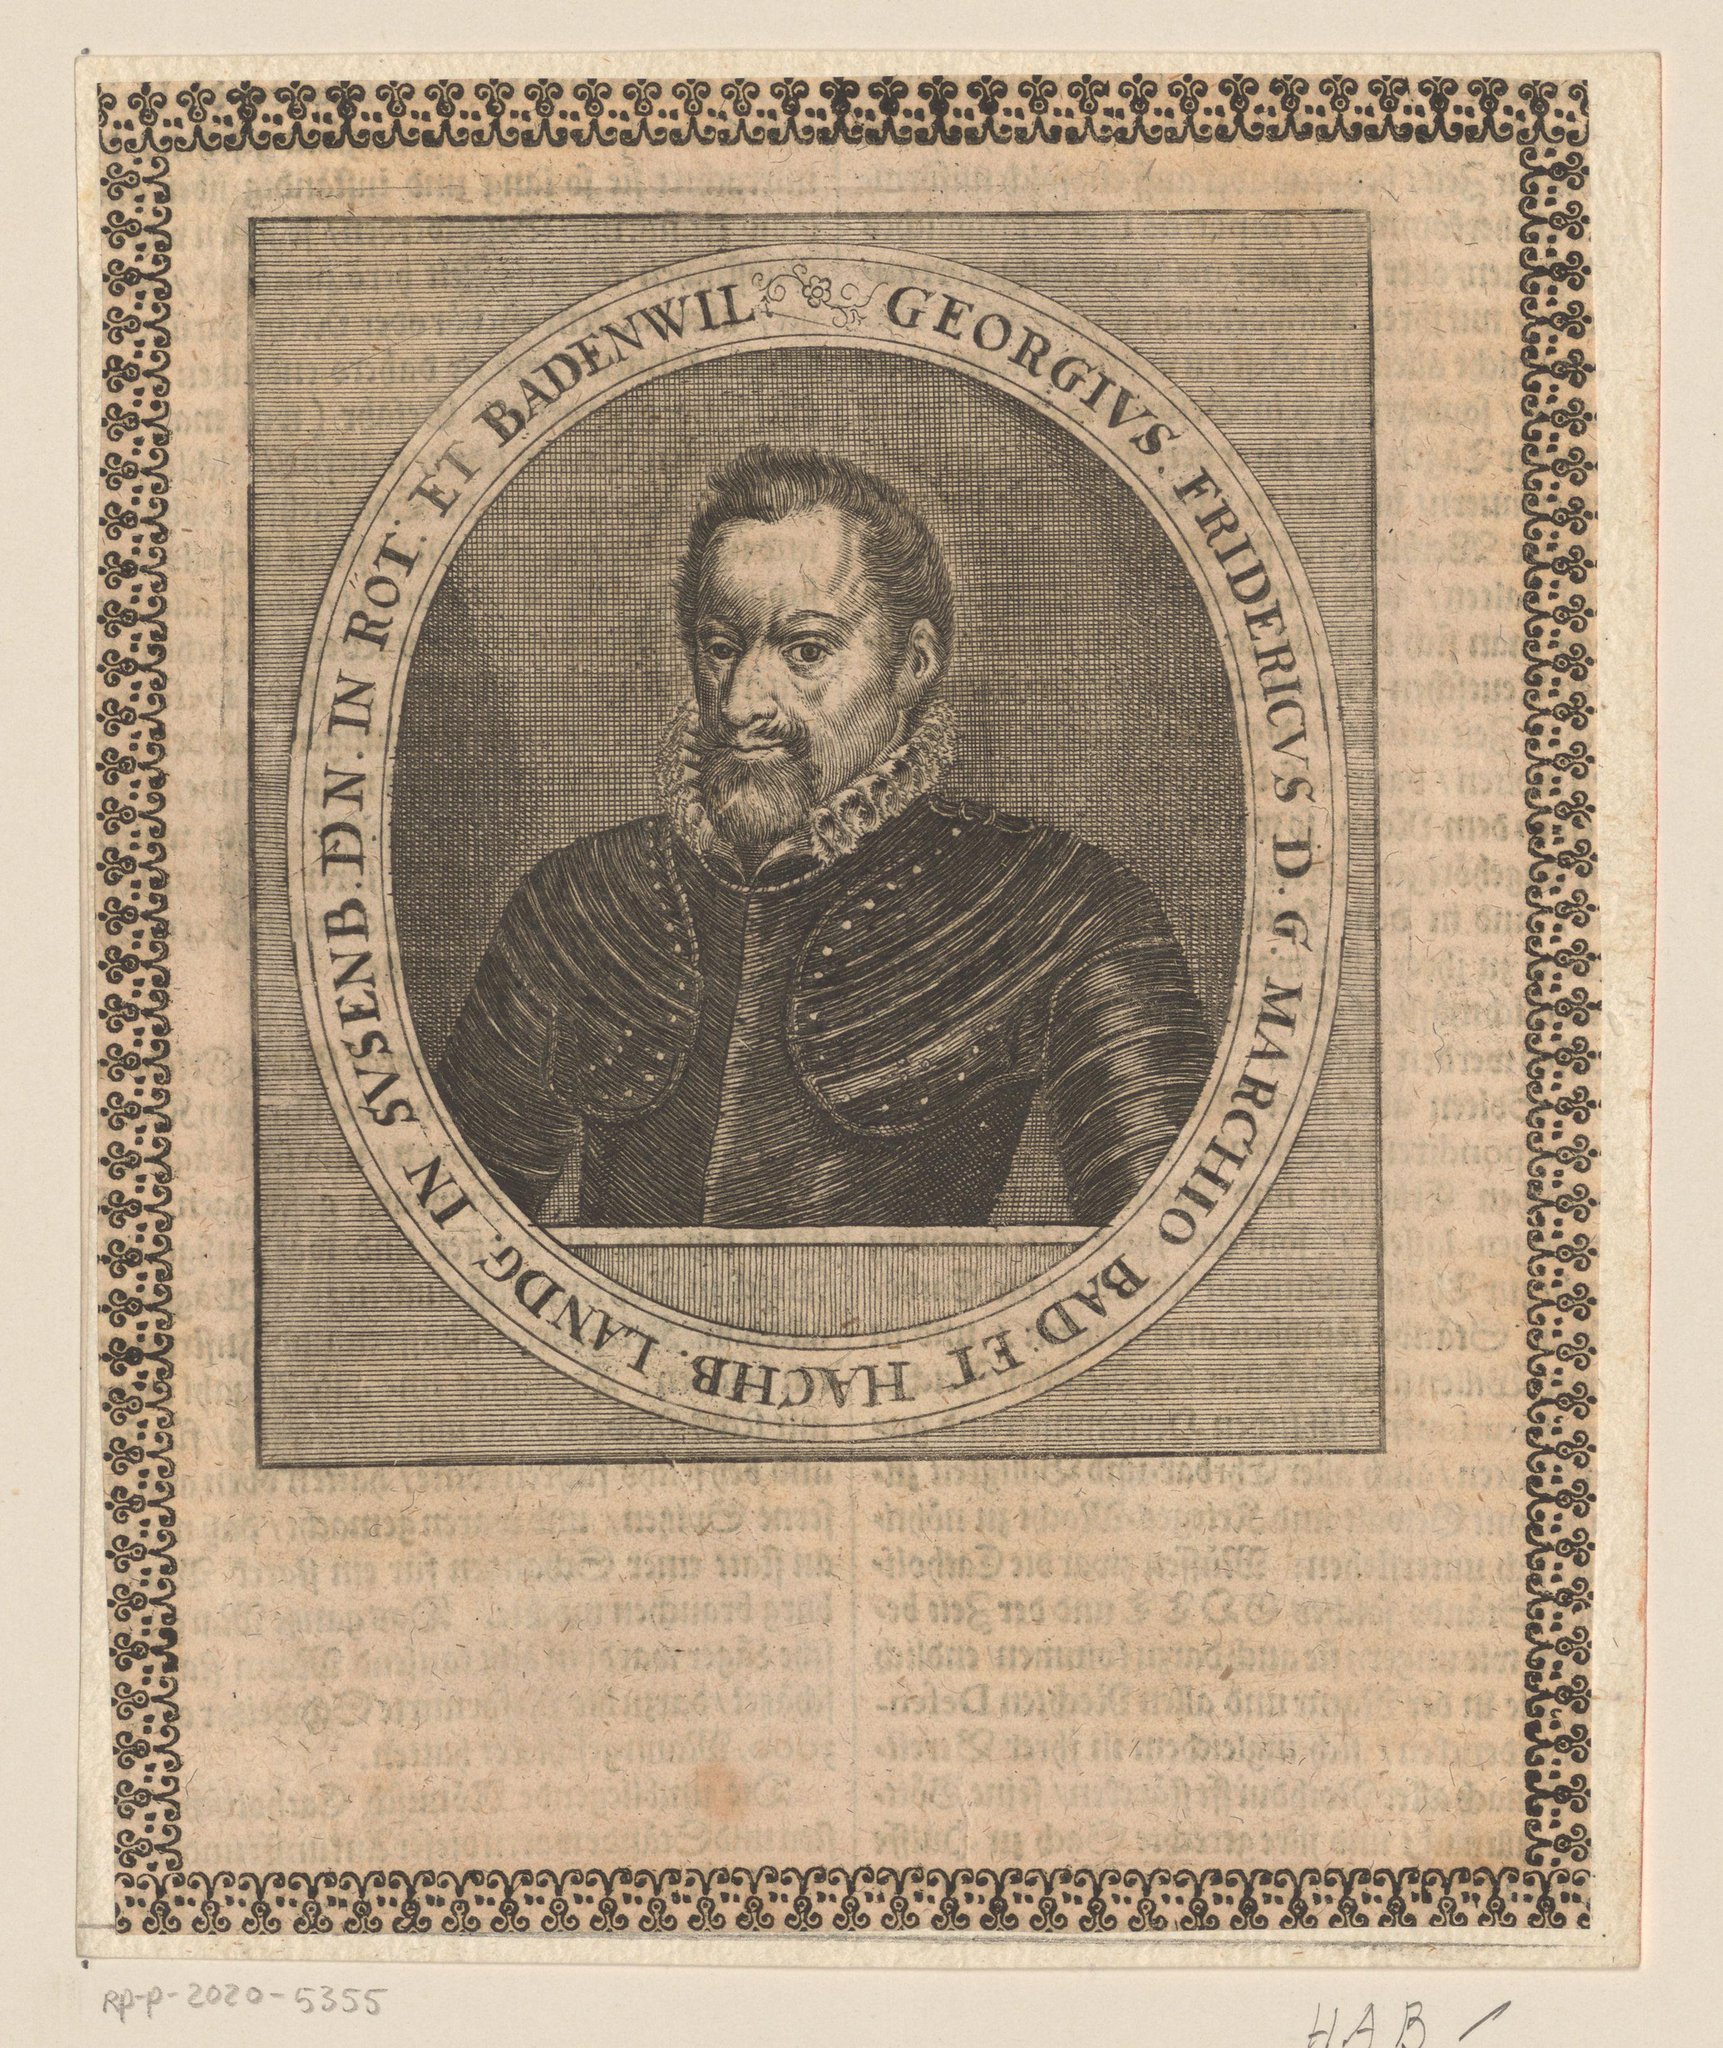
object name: print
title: Portret van Georg Friedrich von Baden-Durlach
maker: Anonymous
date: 1600-1700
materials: paper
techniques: engraving, letterpress printing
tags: commander-in-chief, general, marshal, historical persons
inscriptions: number: ‘440’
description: Tekst in het Latijn in de omlijsting. Omkadering van fleurons.